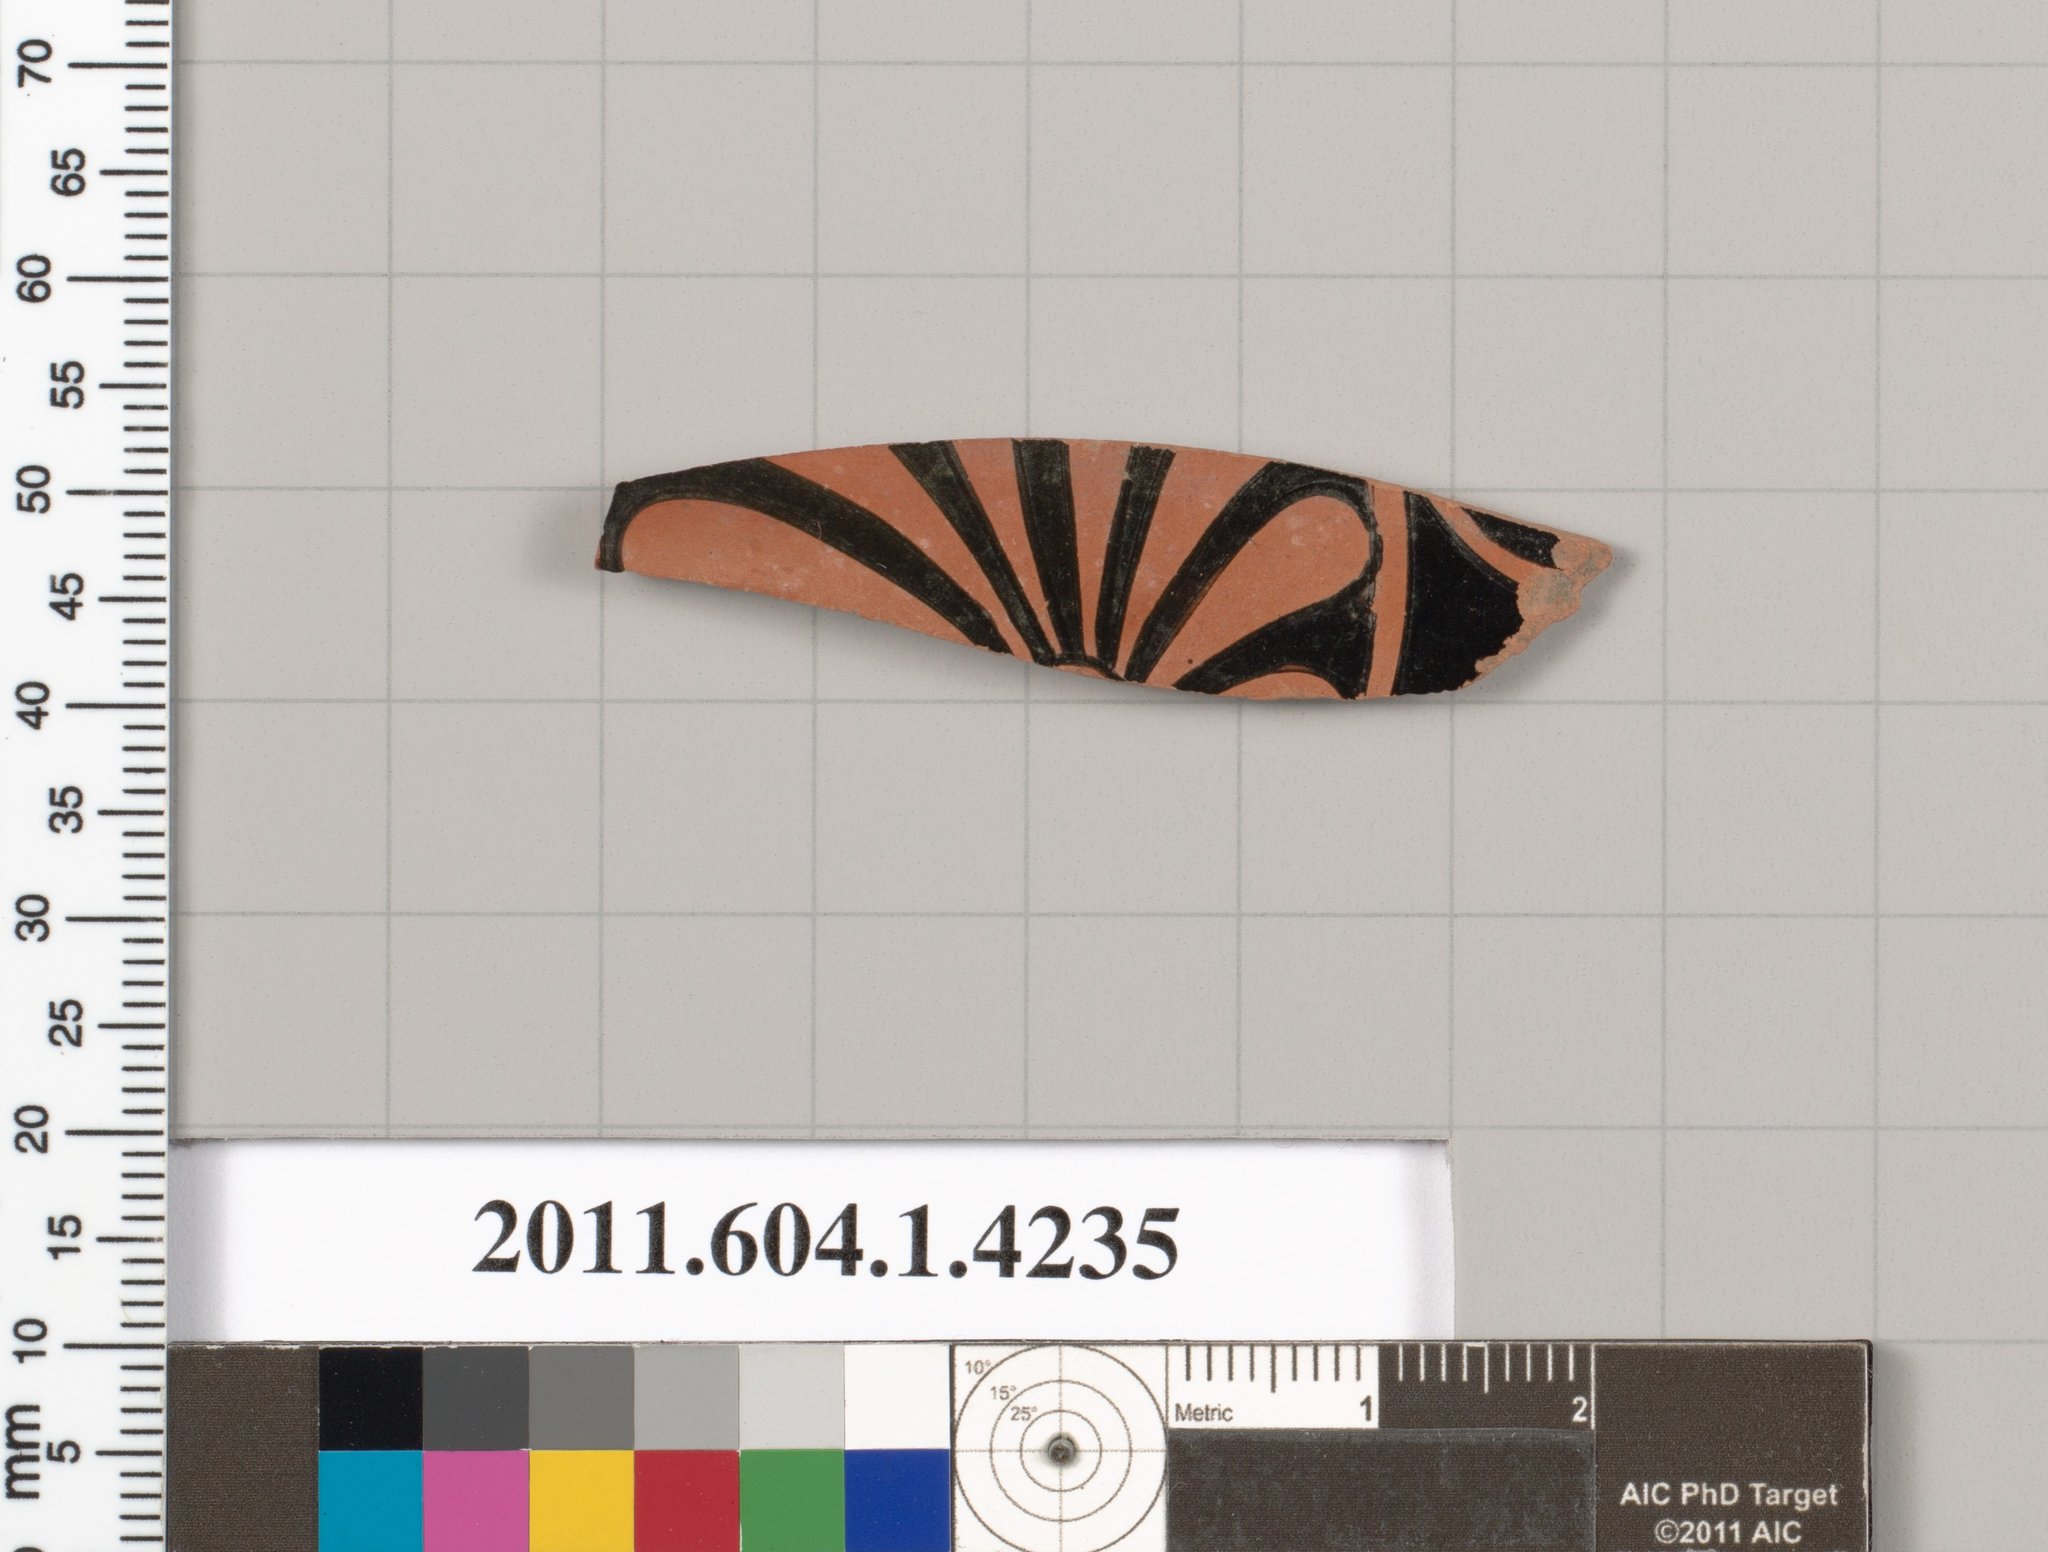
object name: kylix fragment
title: Terracotta fragment of a kylix (drinking cup)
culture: greek, attic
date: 500-476 BCE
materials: terracotta